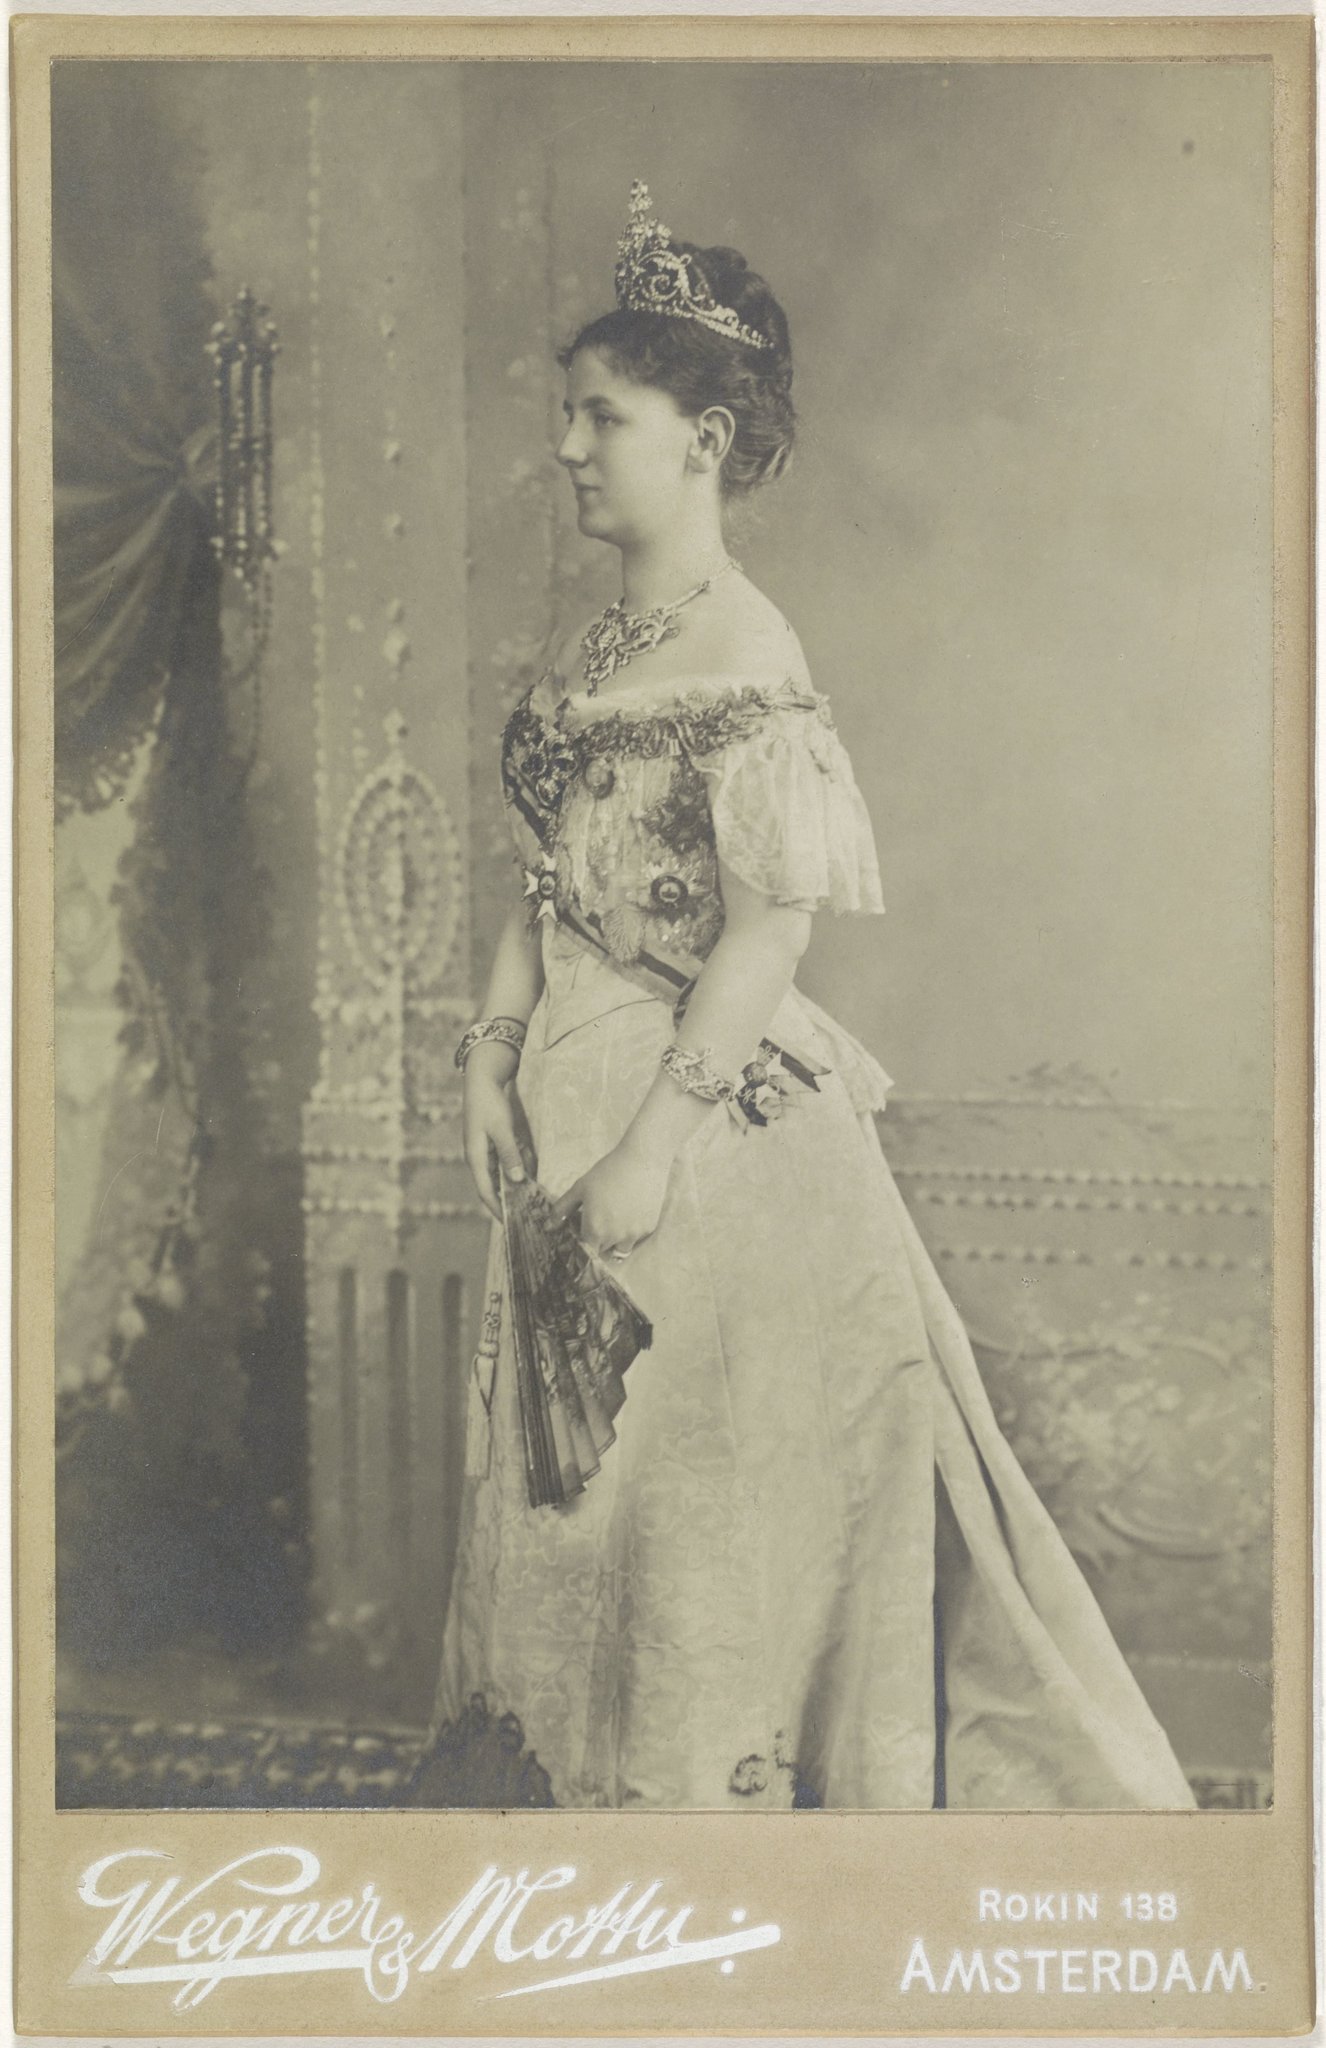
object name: photograph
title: Portret van Wilhelmina, koningin der Nederlanden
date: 1901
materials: cardboard, photographic support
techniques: photography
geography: netherlands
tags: wilhelmina of the netherlands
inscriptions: address: ‘Wegner & Mottu Rokin 138 Amsterdam.’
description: De hier vermelde titel verwijst naar de hoogst verkregen titel van de geportretteerde, niet per se naar de titel die de geportretteerde op deze voorstelling draagt.